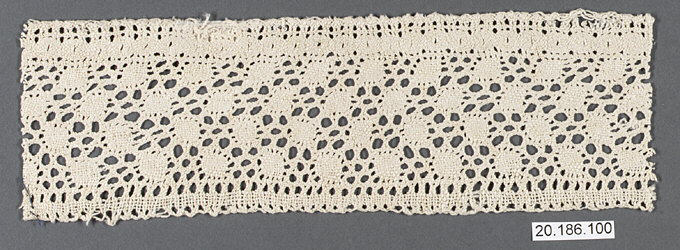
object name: strip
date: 1501-1700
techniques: lace